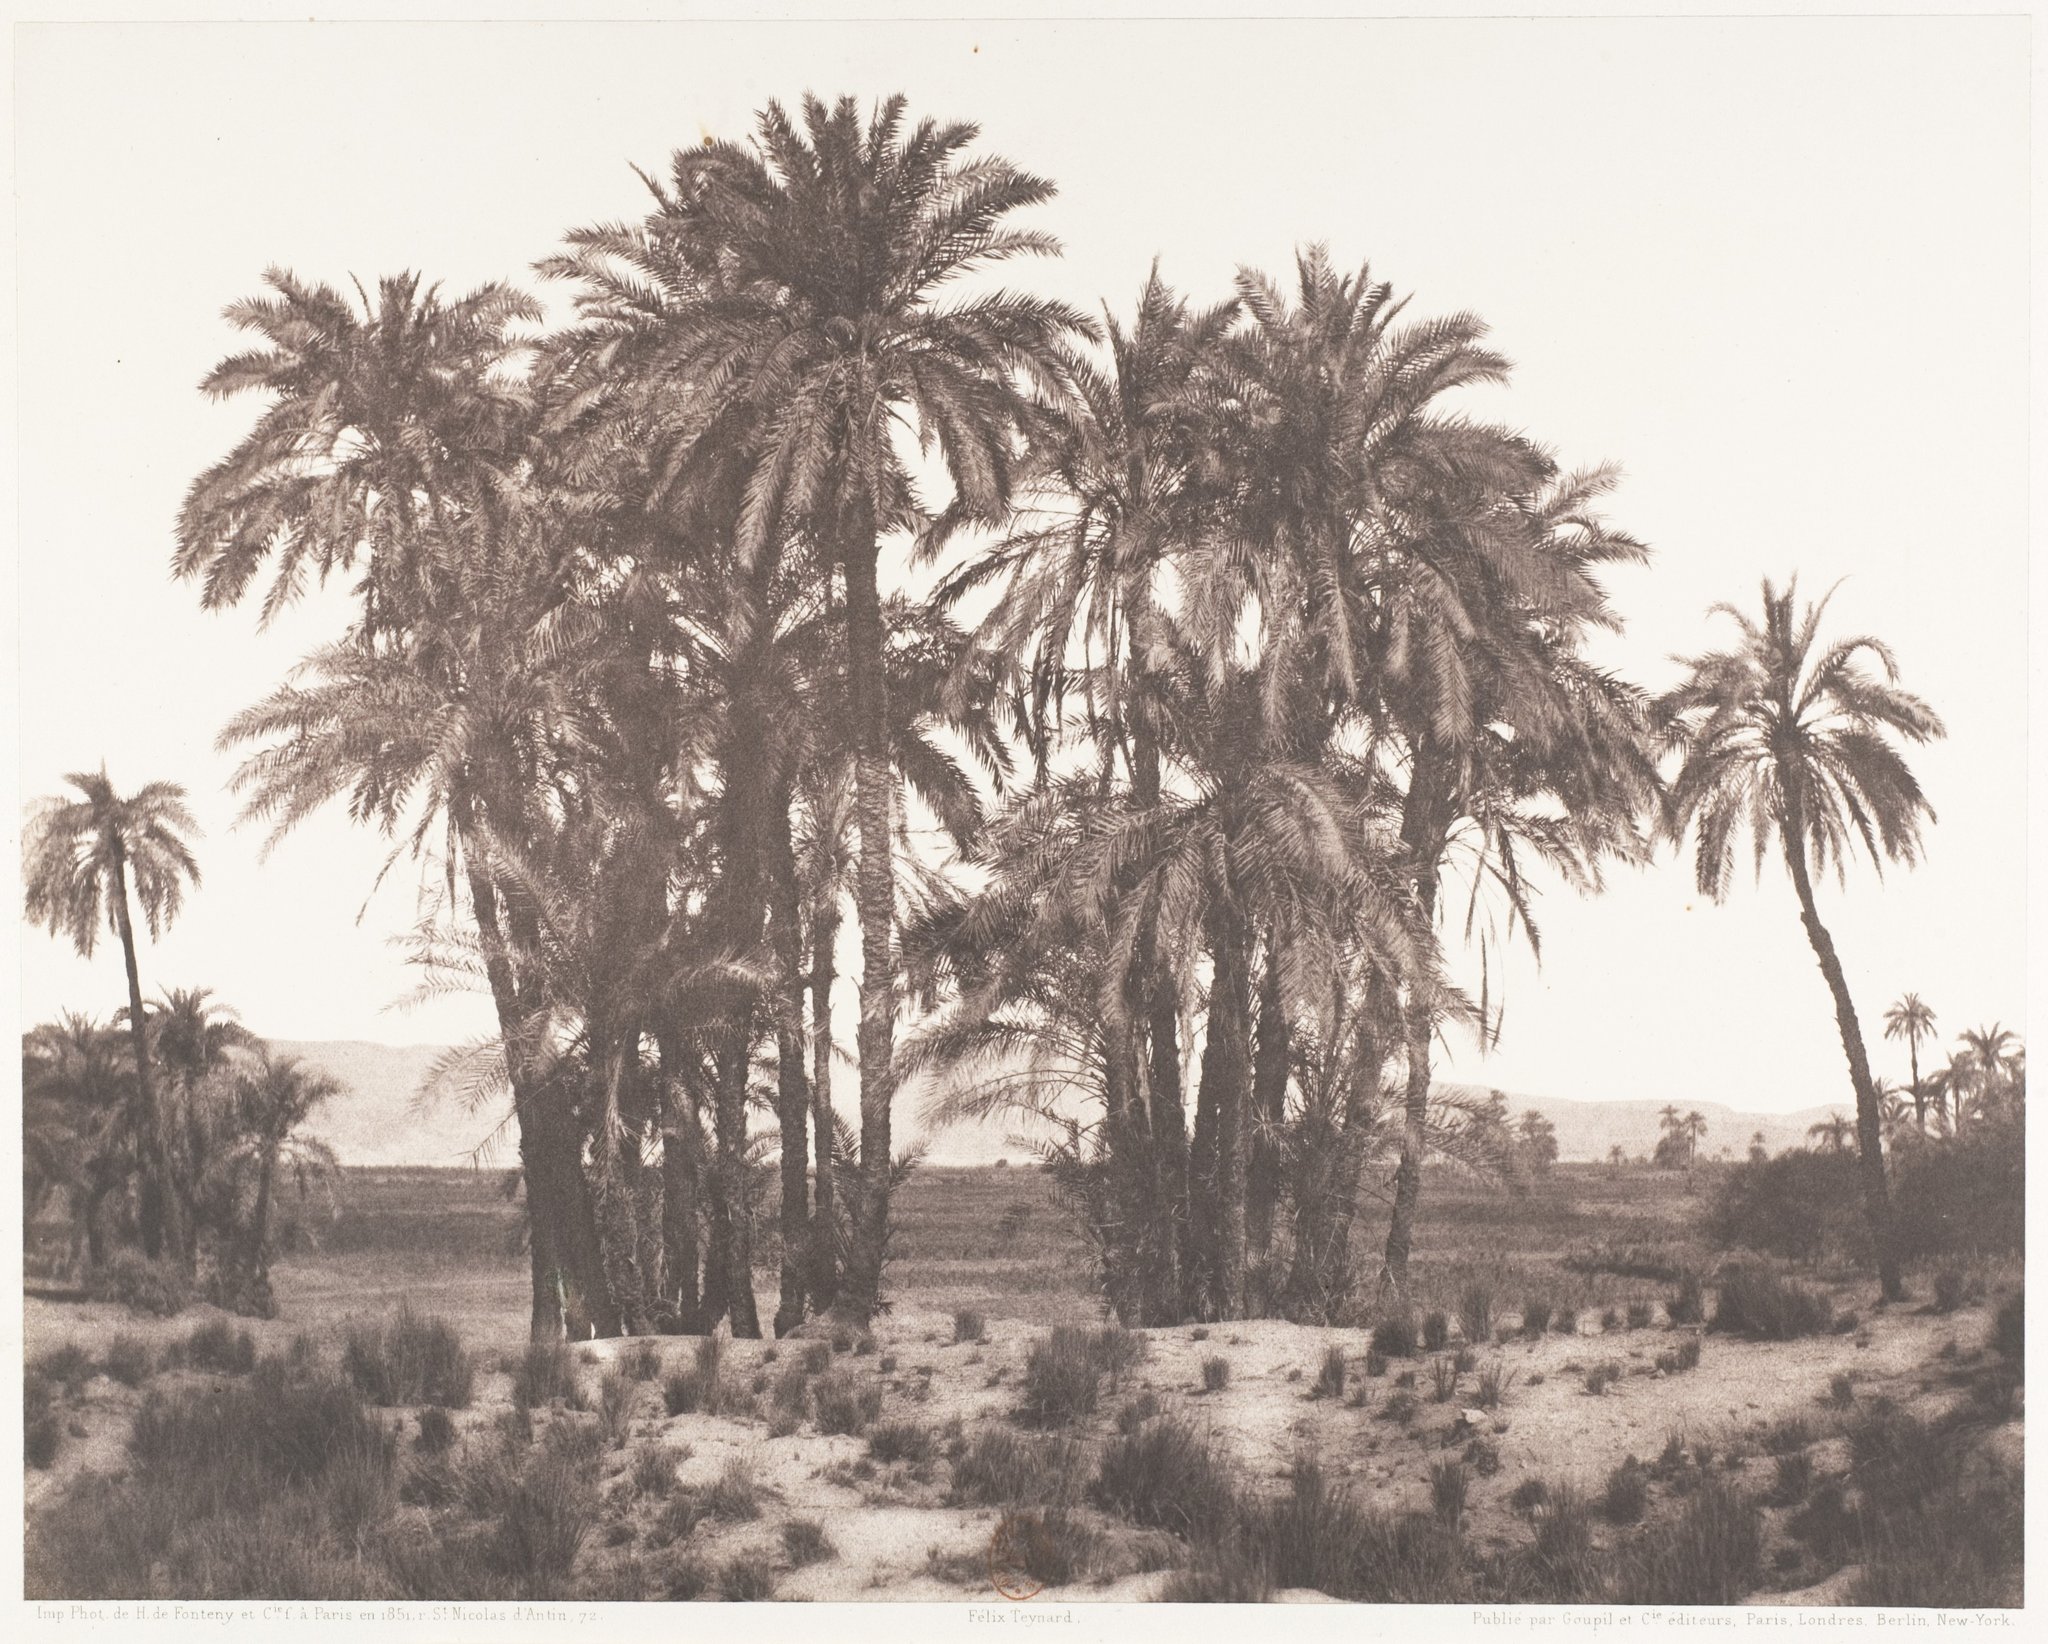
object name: photograph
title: Karnak, Groupe de Dattiers Vu du Point A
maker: félix teynard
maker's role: artist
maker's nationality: french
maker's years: 1817-1892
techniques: paper negative, salted paper print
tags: landscapes,trees